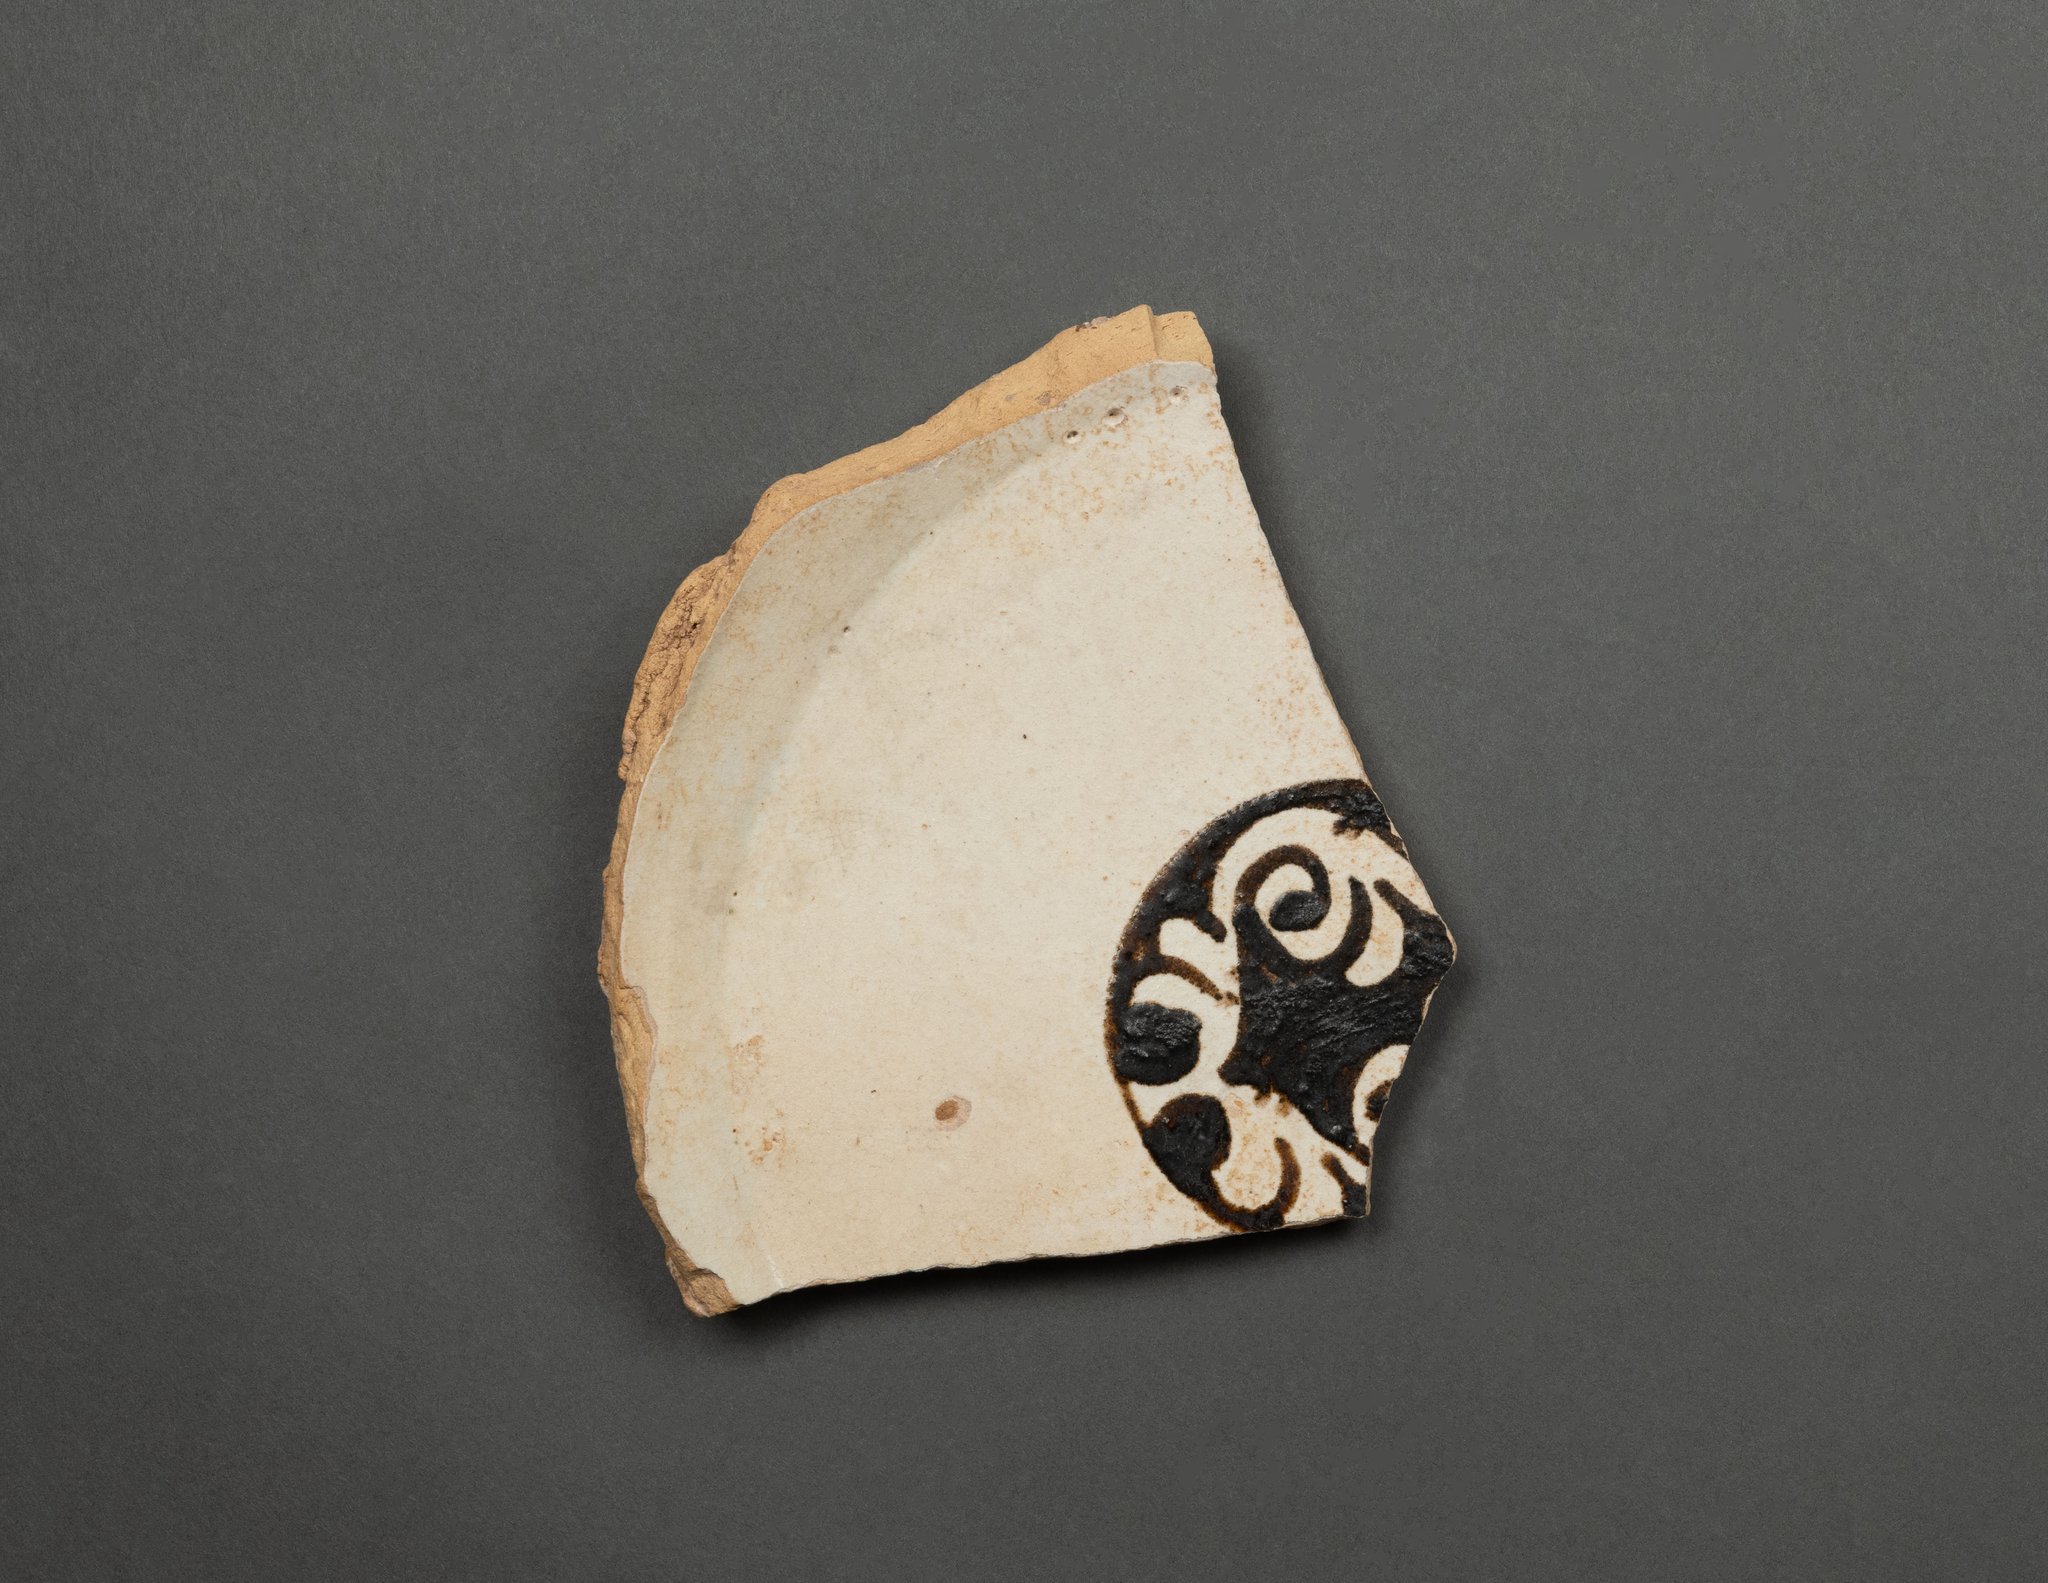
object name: fragment of a bowl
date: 801-1000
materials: earthenware, glaze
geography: iran